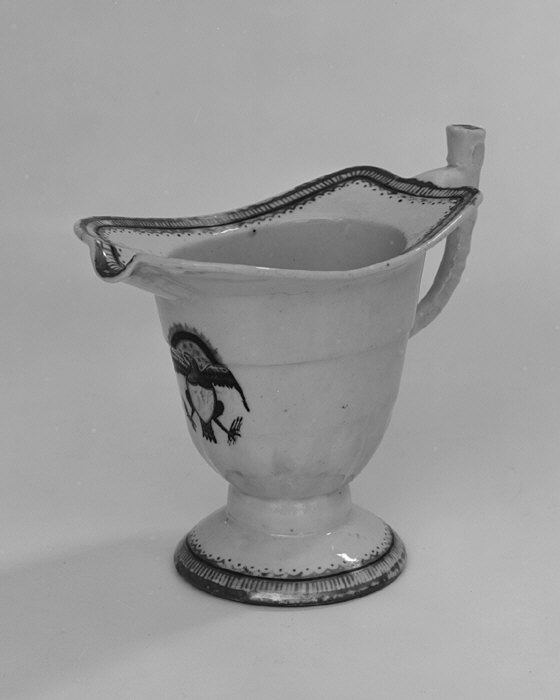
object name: creamer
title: Creamer (part of a service)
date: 1767-1833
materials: hard paste porcelain